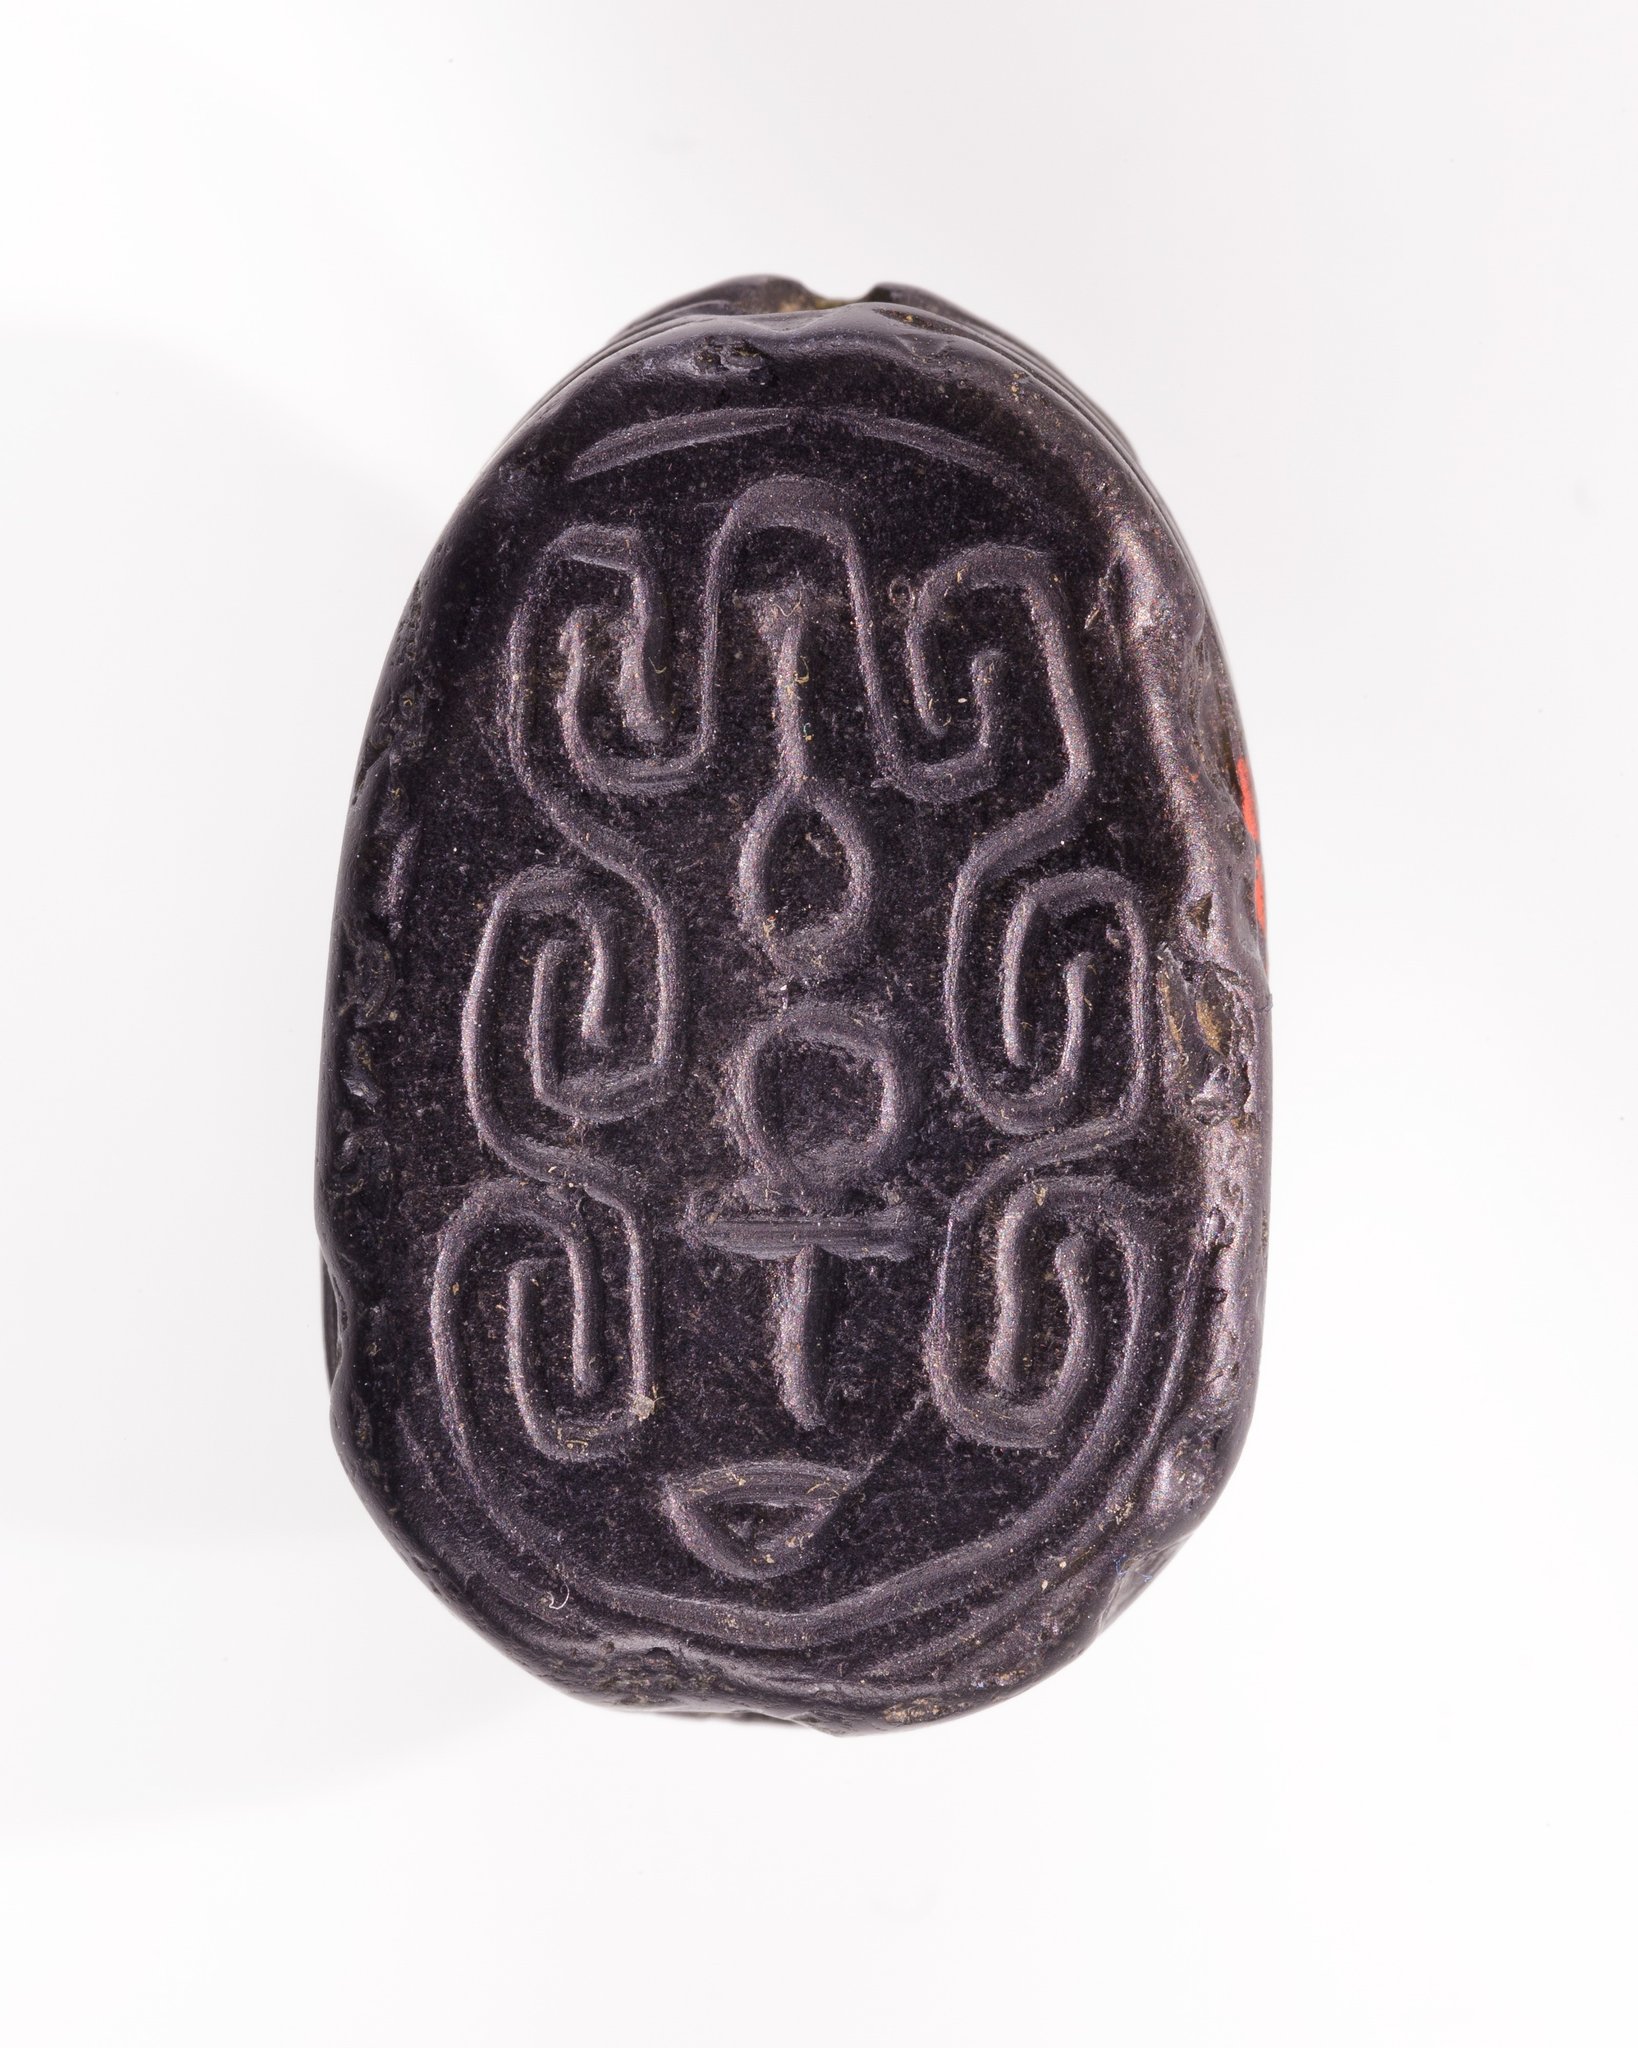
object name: scarab, scroll, hieroglyph, nefer, lotus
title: Scarab Inscribed with Hieroglyphs in a Scroll Border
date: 1802-1640 BCE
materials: obsidian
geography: egypt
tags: scarabs